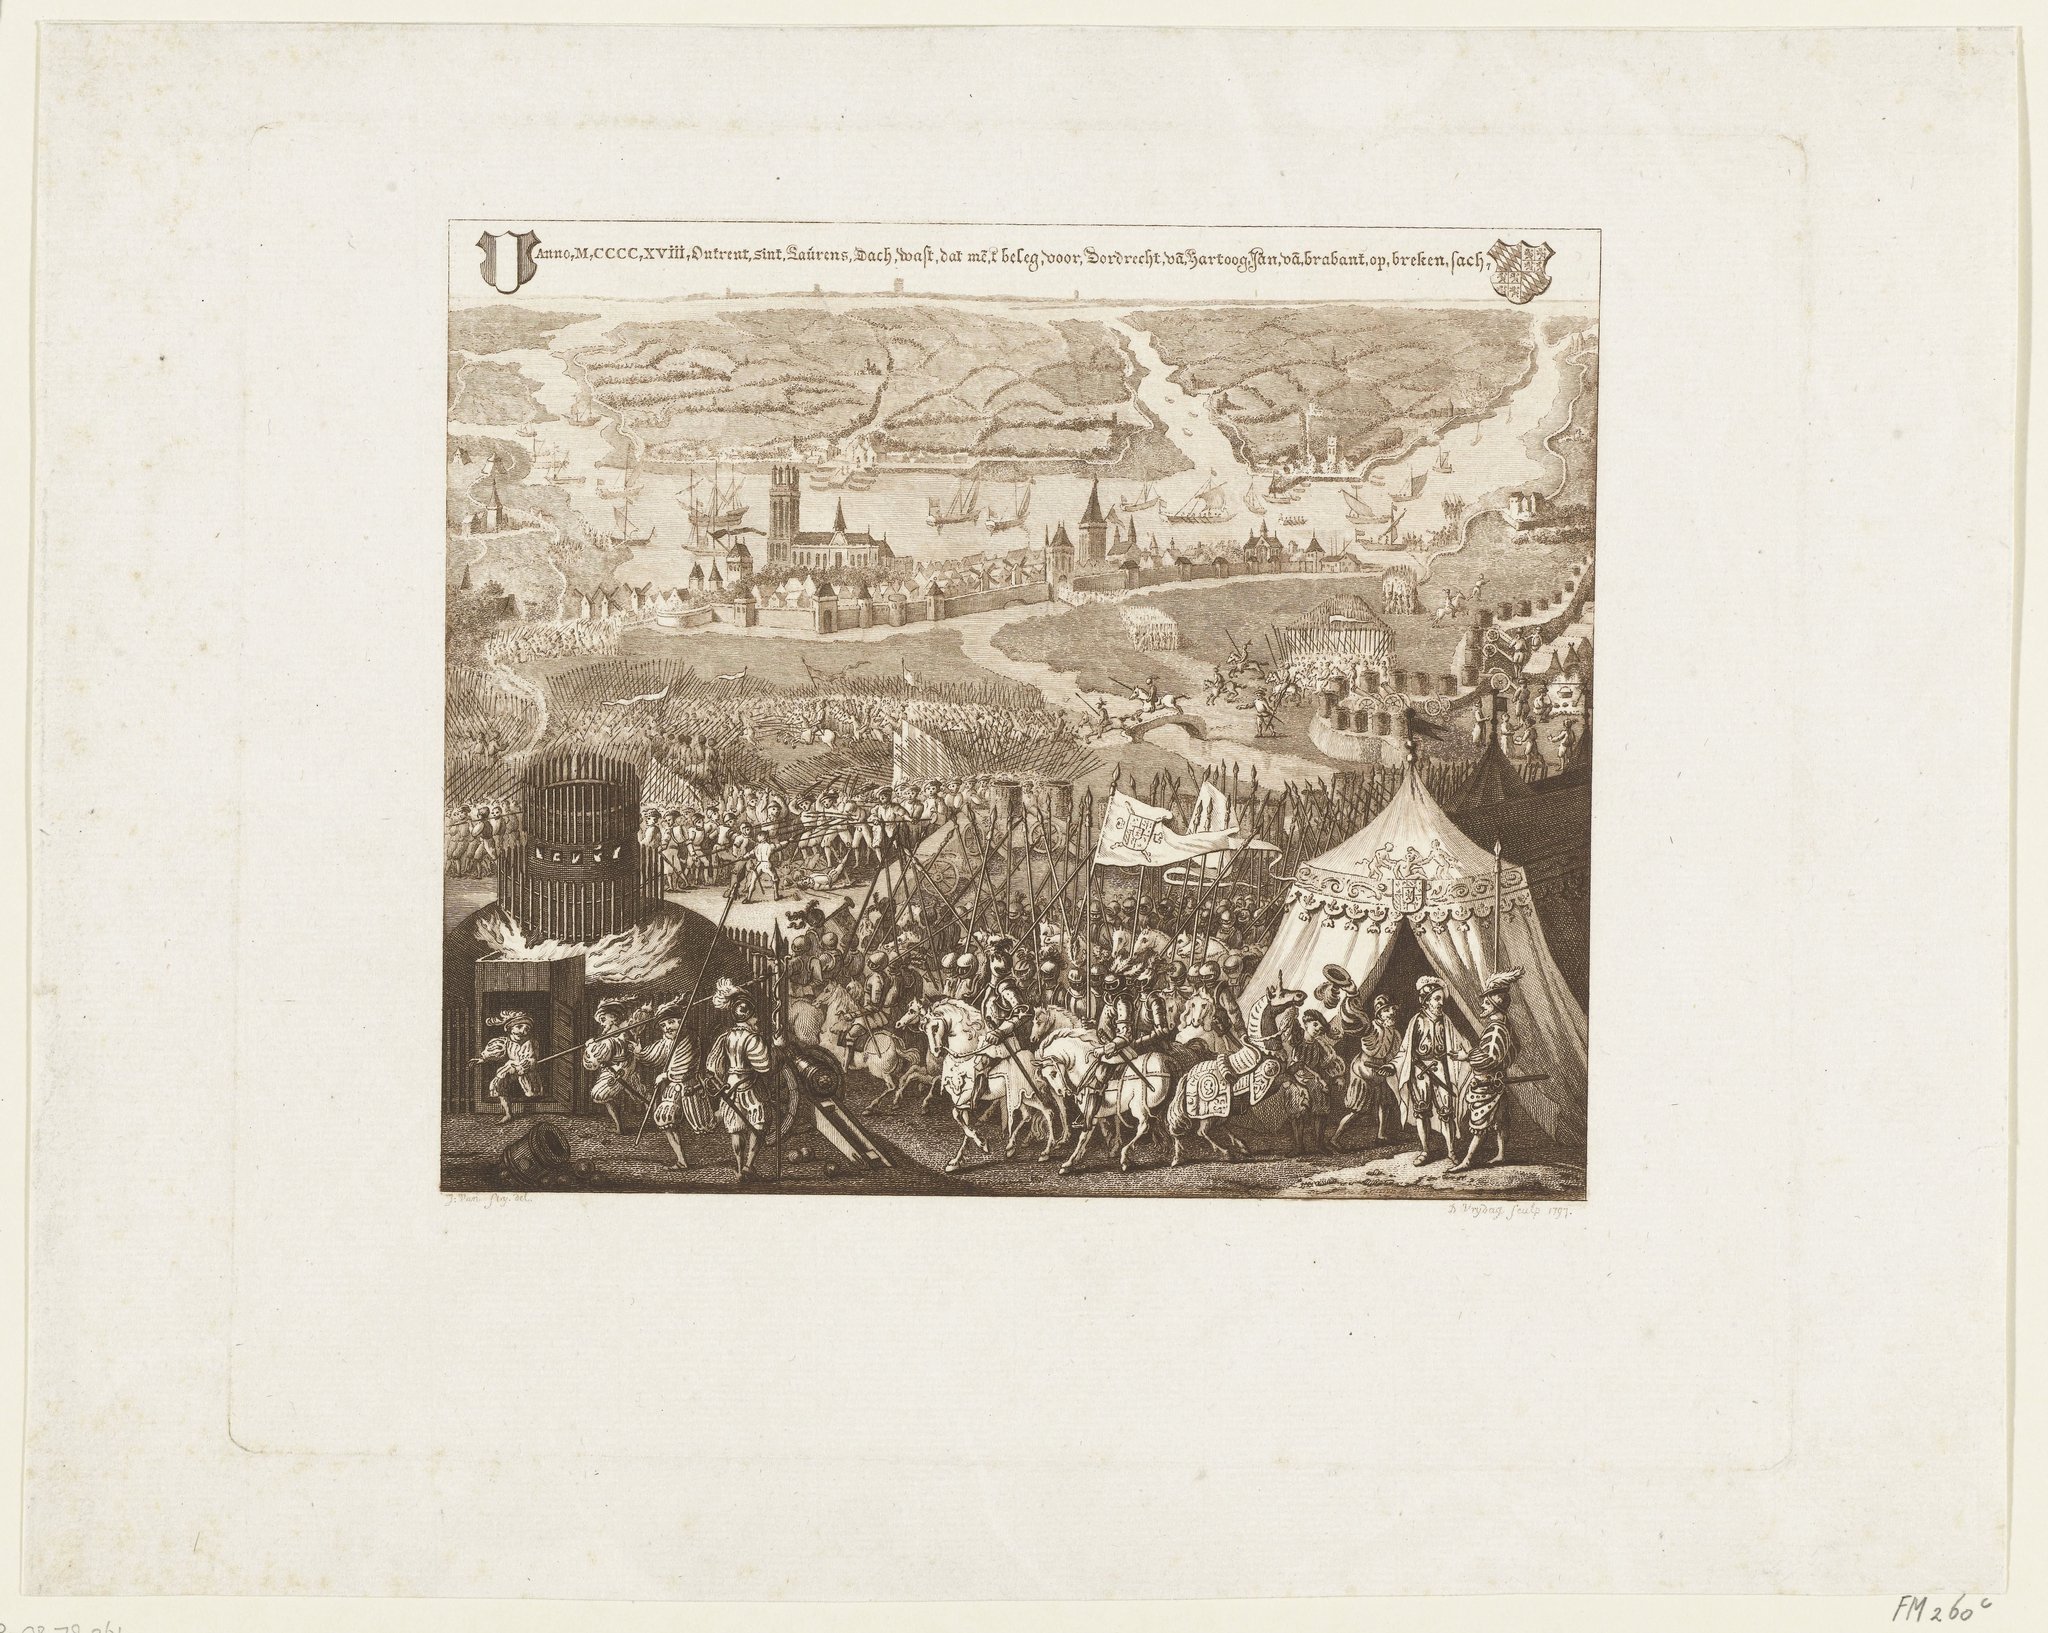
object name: print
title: Opbreken van het beleg van Dordrecht, 1418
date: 1797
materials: paper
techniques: etching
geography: netherlands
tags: siege, position war, dordrecht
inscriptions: date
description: Het opbreken van het beleg van Dordrecht, 8 augustus 1418. Kopie naar een oud schilderij op het Raadhuis van Dordrecht. Op de voorgrond het legerkamp van de belegeraars, daarachter schermutselingen, in de verte de stad Dordrecht. Met de oorspronkelijke inscriptie boven de voorstelling.